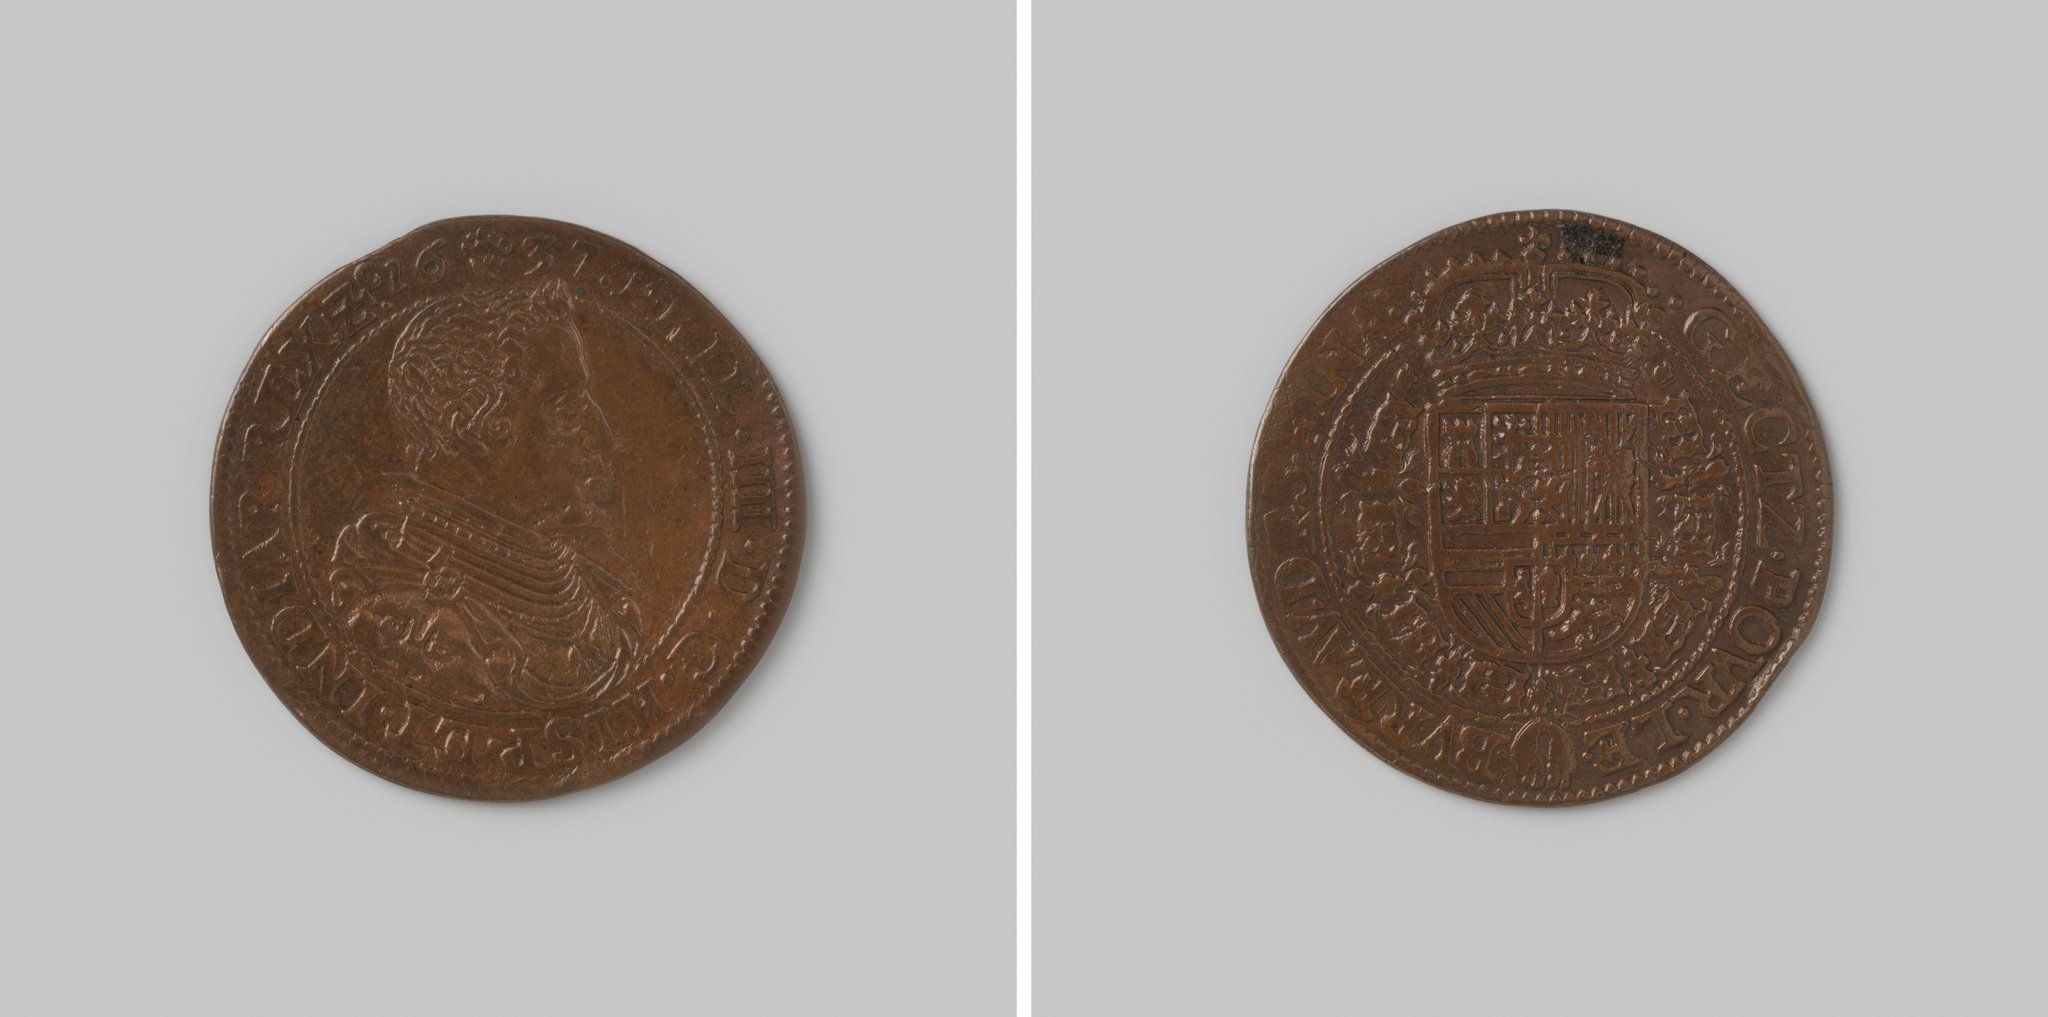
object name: jeton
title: Rekenpenning uit Brussel voor het Bureau van Financien 1637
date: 1637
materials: copper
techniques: striking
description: Koperen penning, op de voorzijde het borstbeeld van Philips IV naar rechts met omschrift, op de keerzijde het gekroonde Spaanse wapenschild omhangen met de keten van het Gulden Vlies, met omschrift.